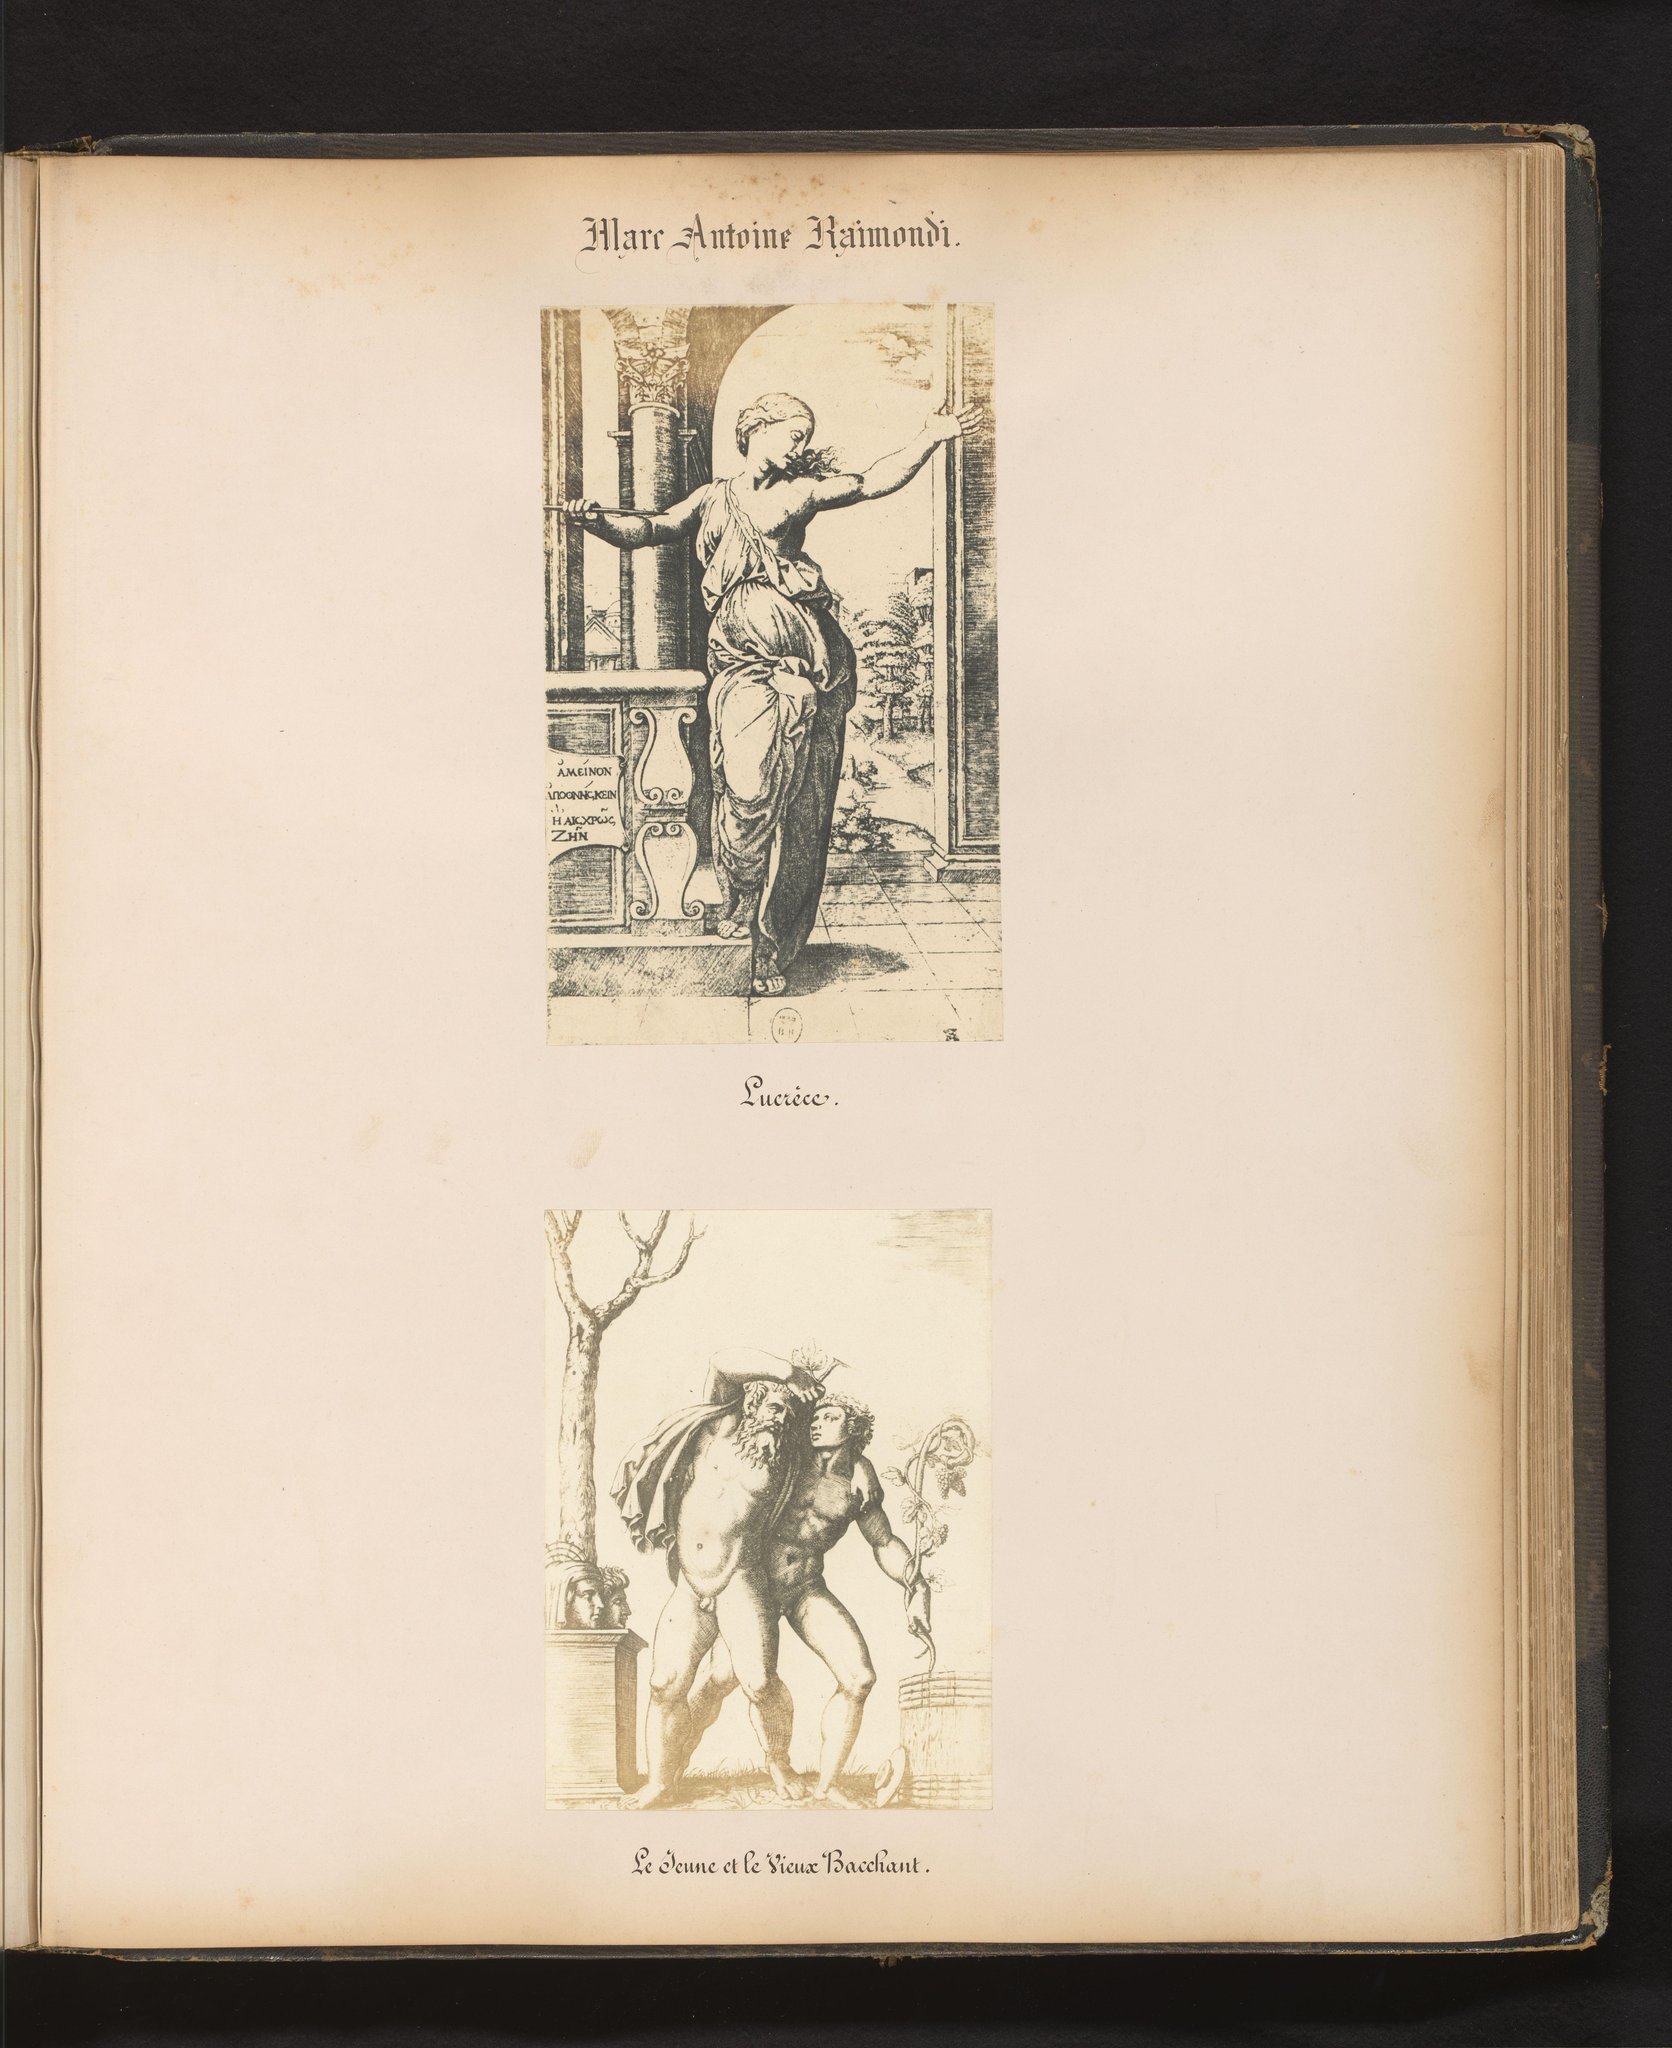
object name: photograph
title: Marc Antoine Raimondi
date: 1848-1853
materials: photographic support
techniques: salted paper print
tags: (story of) lucretia